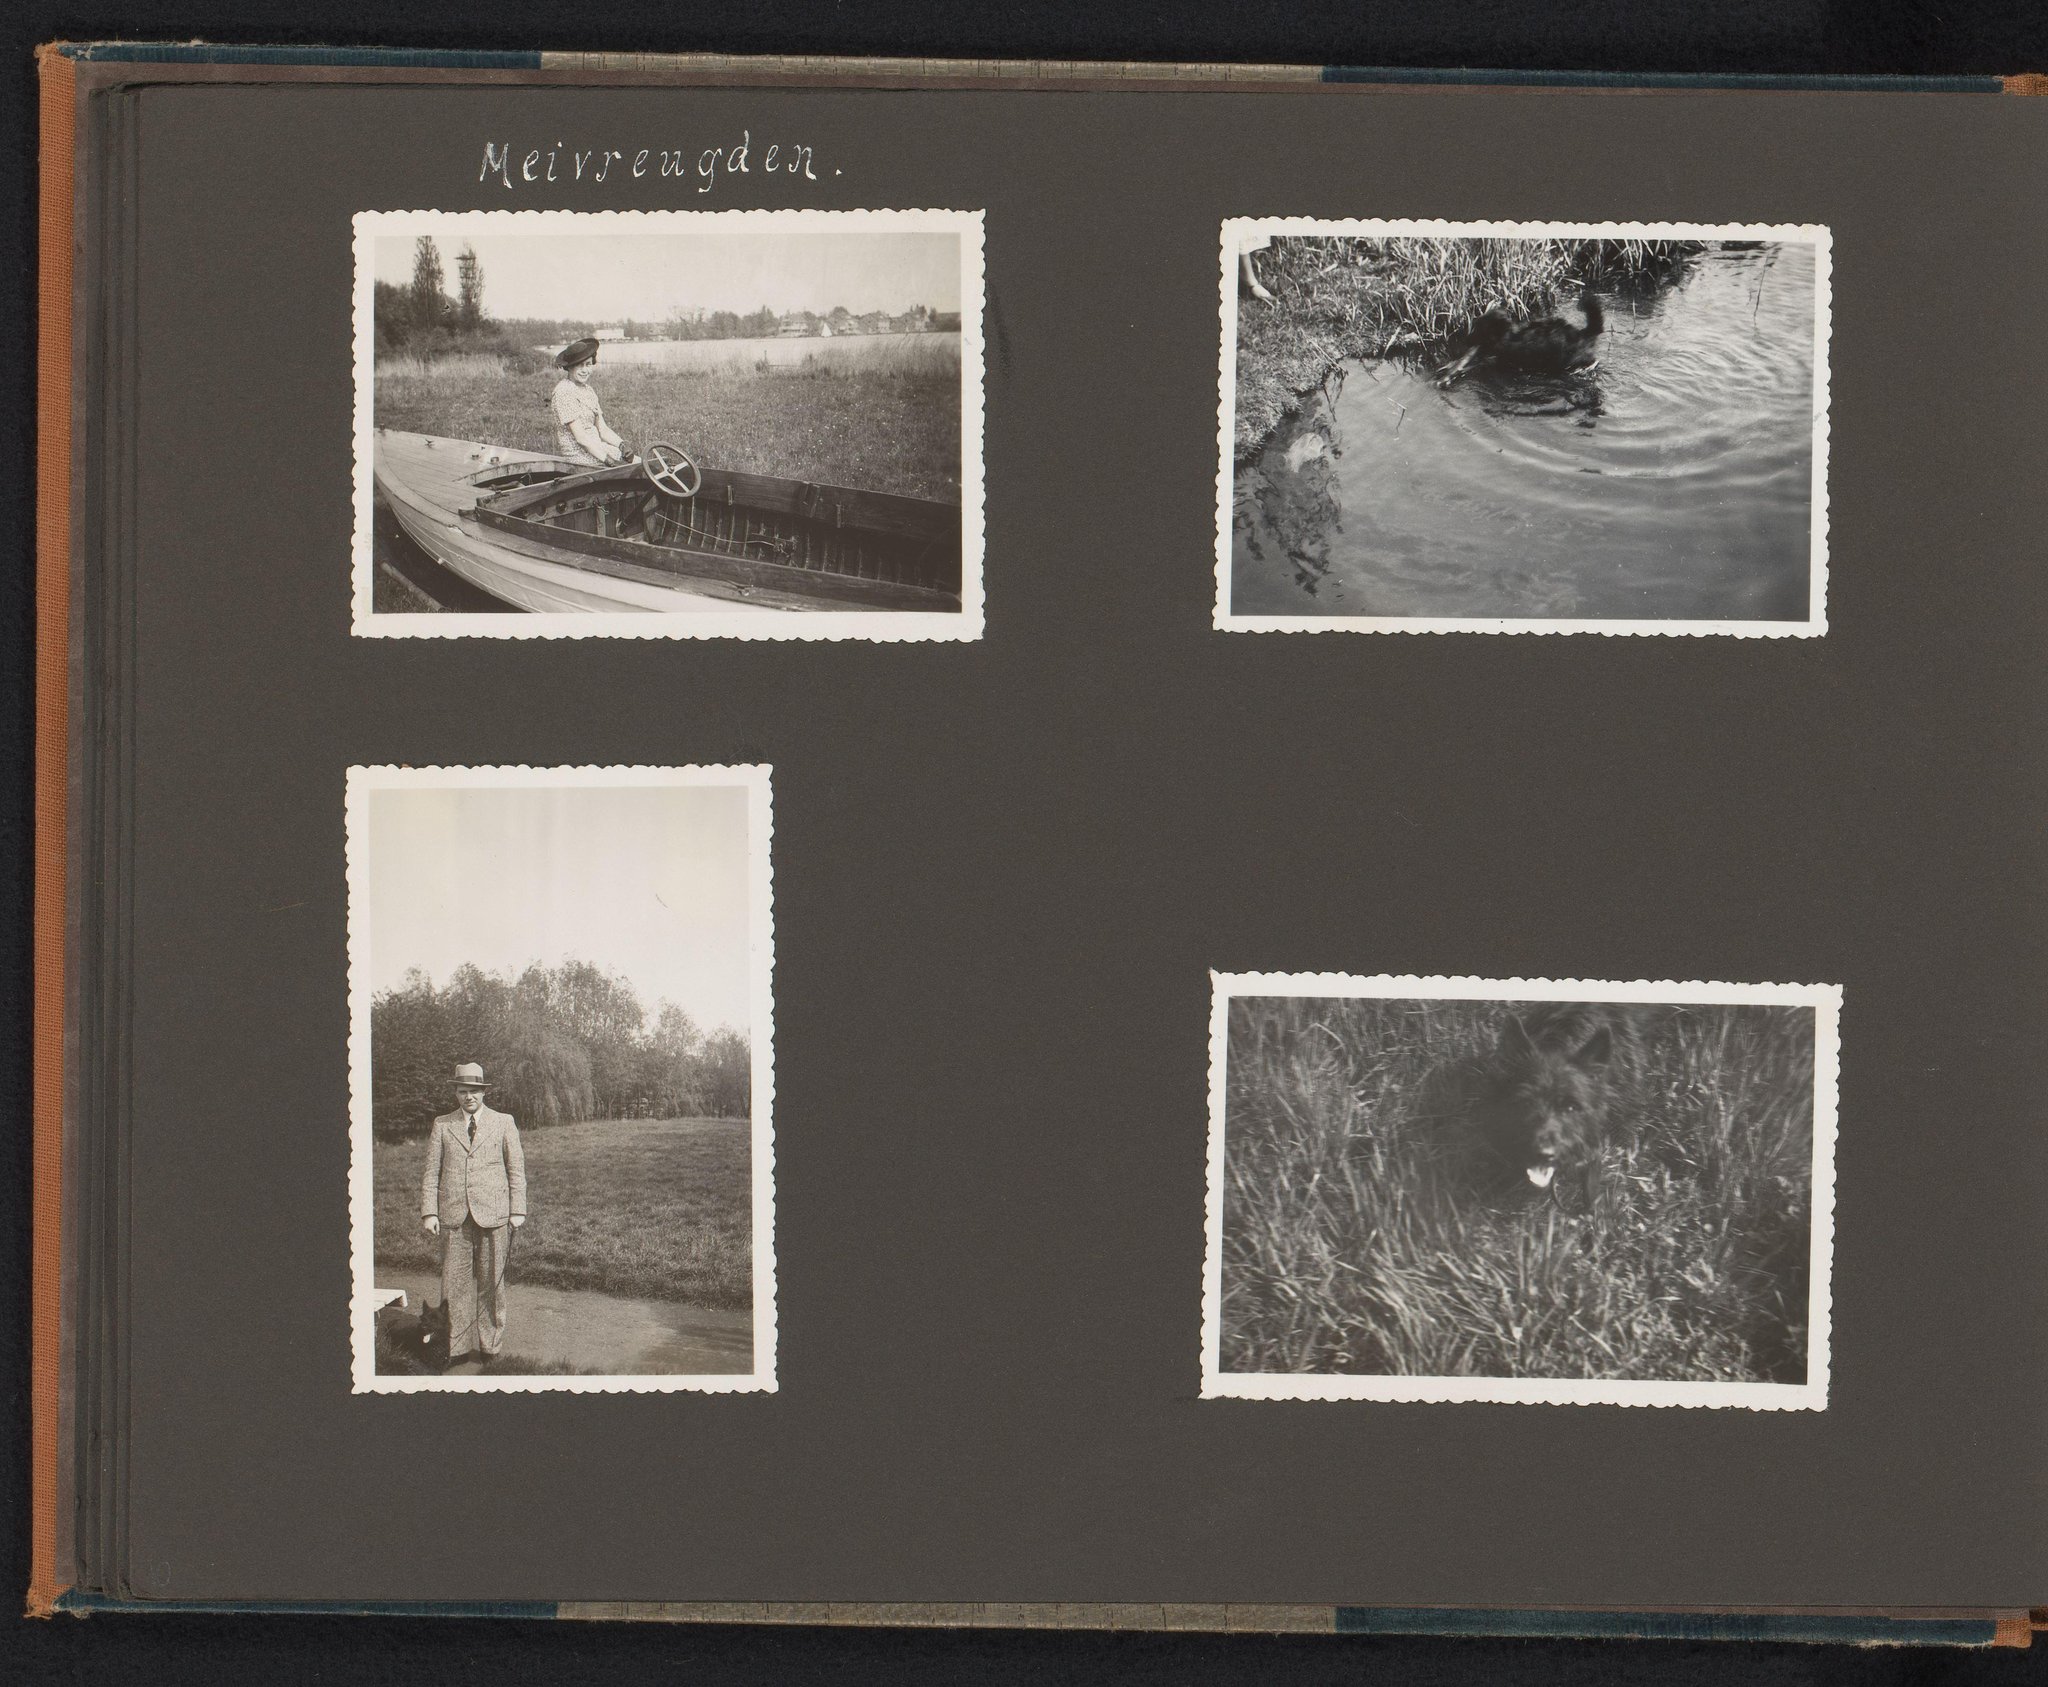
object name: photograph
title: Echtpaar Berti Hoppe en Herman Besselaar op stap met de hond in Plaswijck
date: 1905-1936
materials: cardboard, paper, photographic support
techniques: gelatin silver print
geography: rotterdam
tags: herman besselaar, berti hoppe, historical persons - bb - woman, historical persons, windmill in landscape, walking the dog, rotterdam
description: vier foto's gemaakt tijdens een dag uit in mei 1936. Deze pagina maakt deel uit van een album.